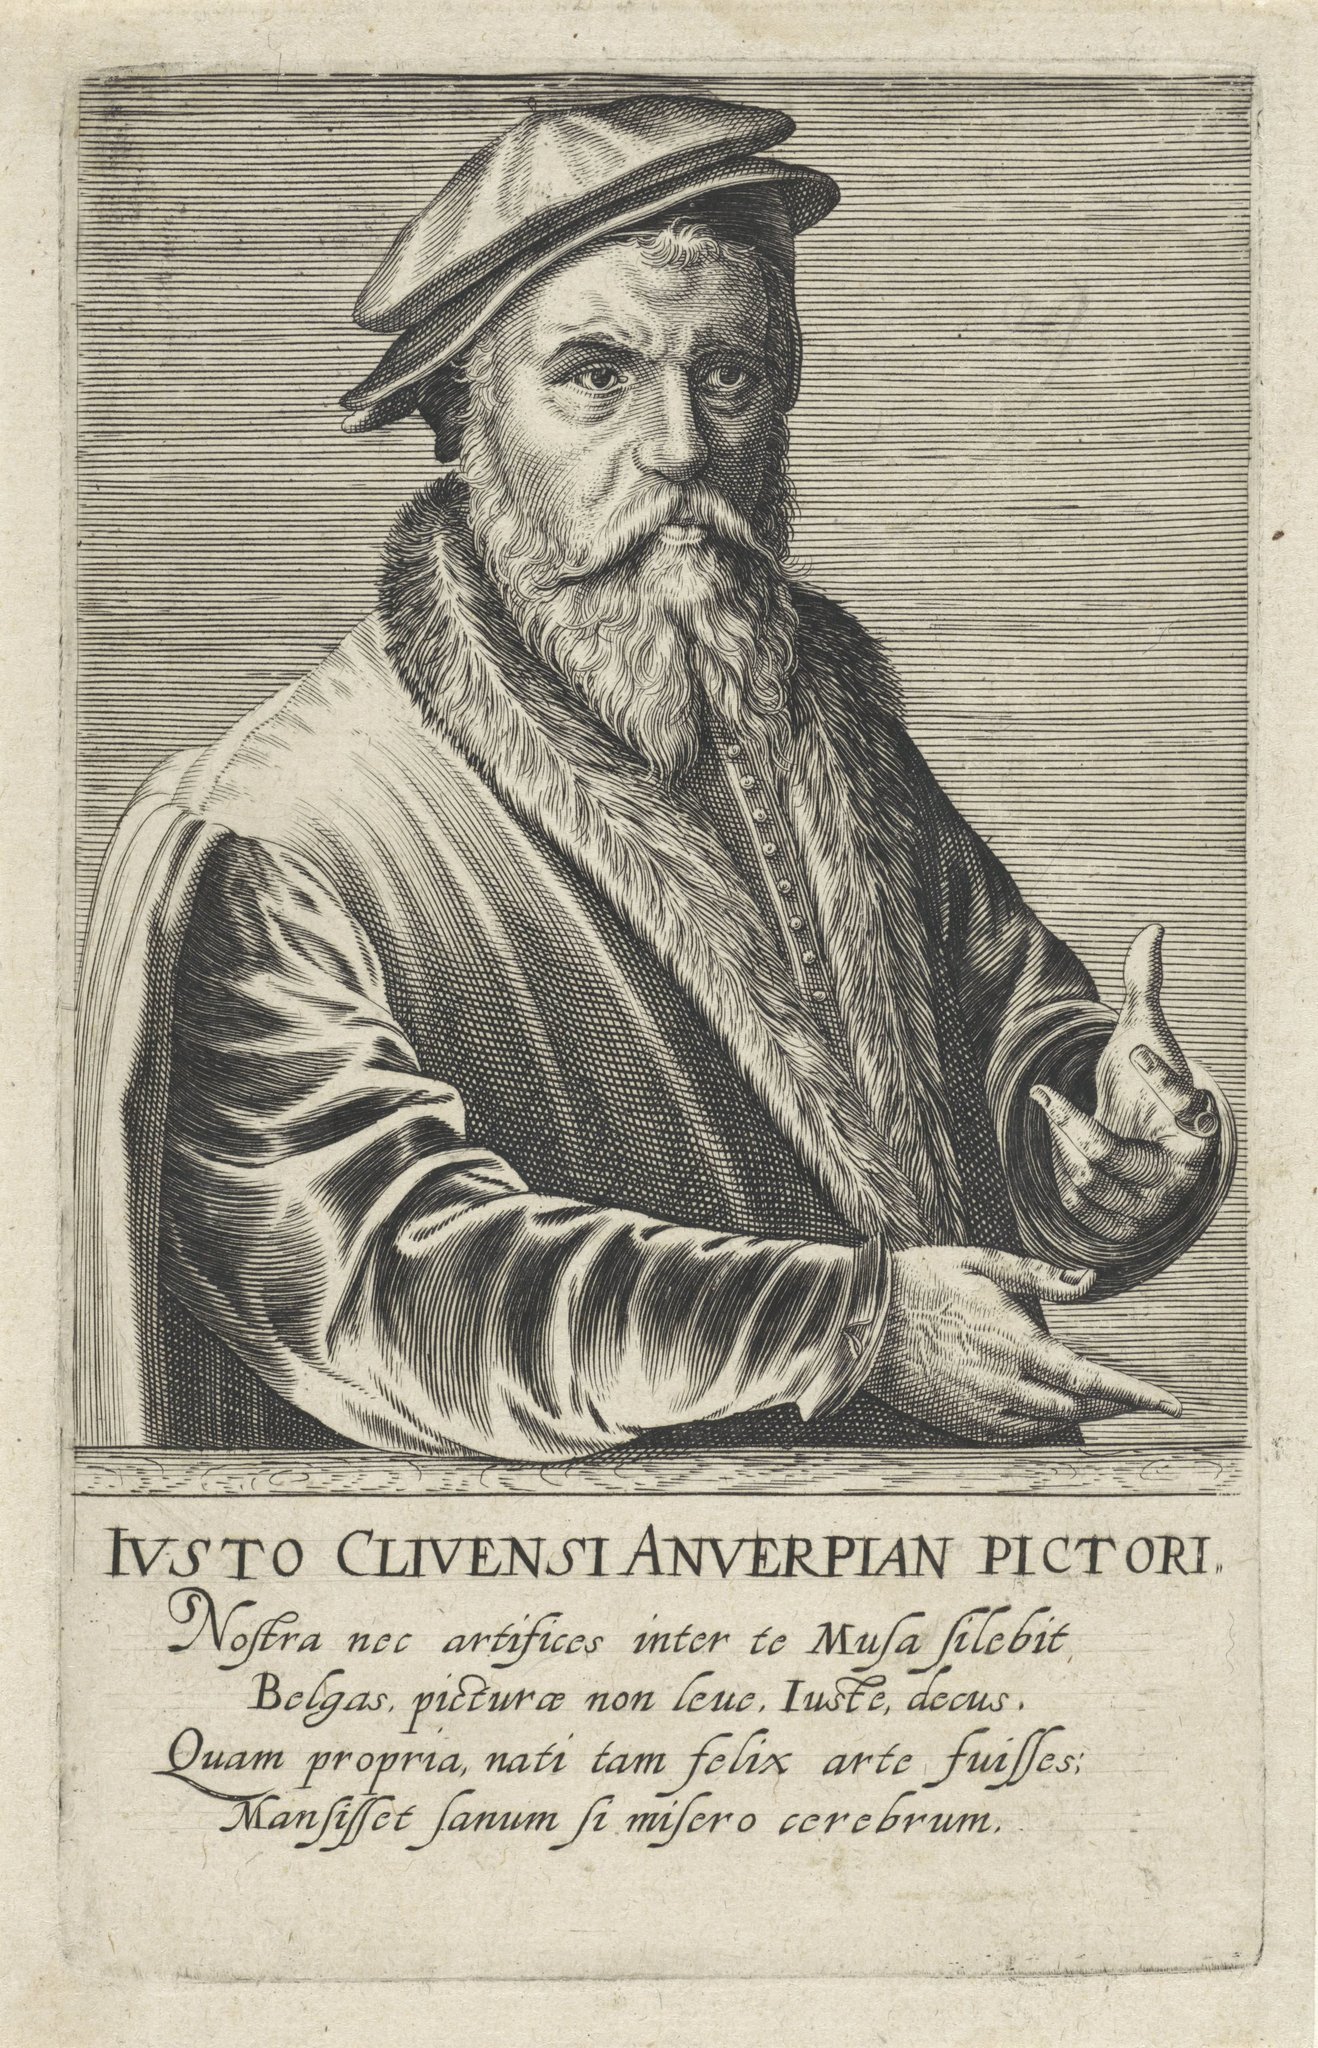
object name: print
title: Pictorum aliquot celebrium praecipuae Germaniae Inferioris effigies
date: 1610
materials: paper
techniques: engraving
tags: cleves, antwerp, painter, draughtsman, joos van cleve, portrait, self-portrait of painter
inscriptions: collector's mark: Lugt 2228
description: In de marge een vierregelig onderschrift in het Latijn.